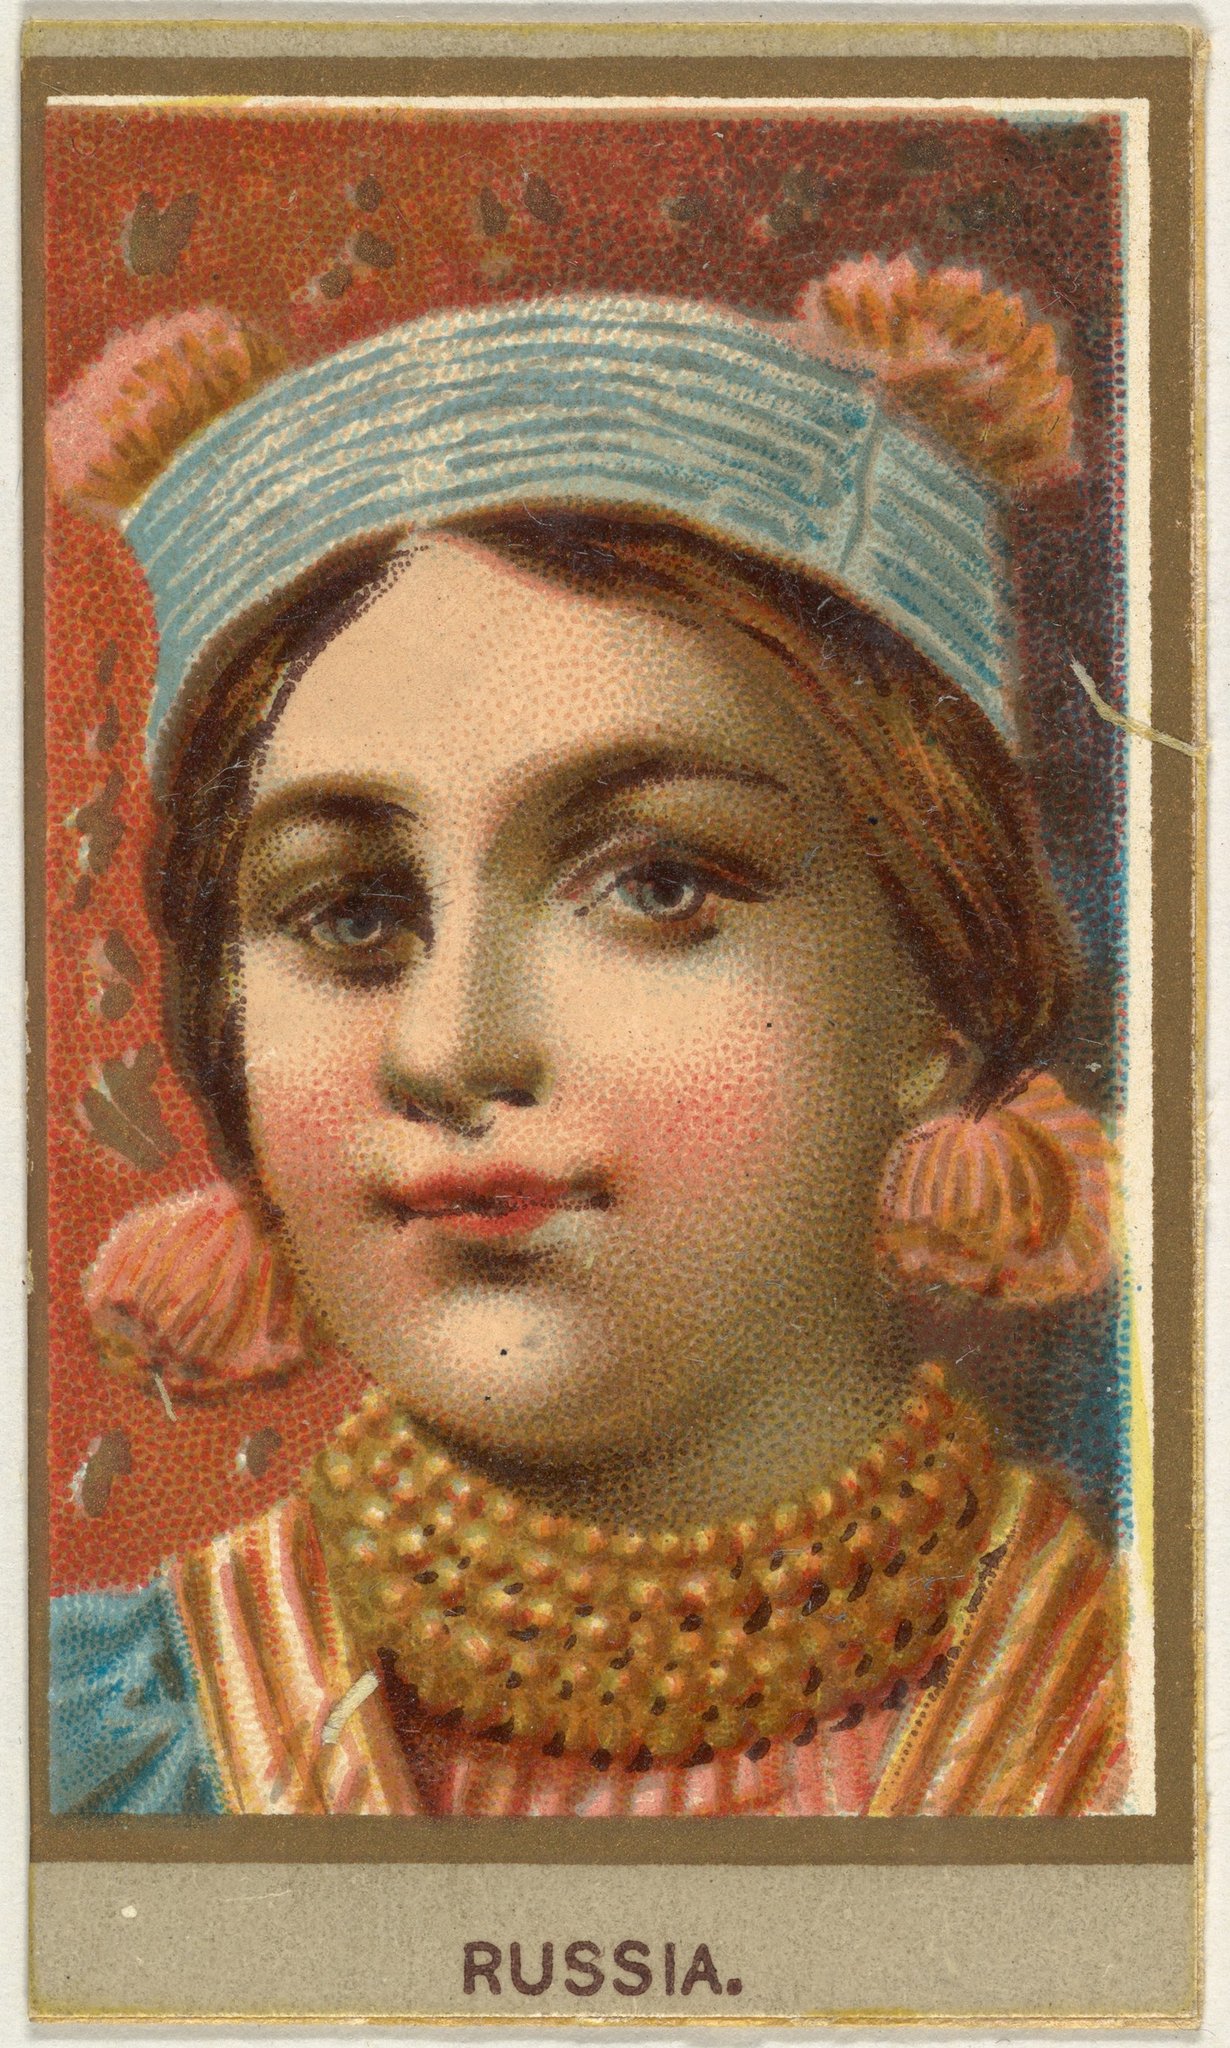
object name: print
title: Russia, from the Races of Mankind series (T181) issued by Abdul Cigarettes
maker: abdul cigarettes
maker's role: publisher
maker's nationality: american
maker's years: 1881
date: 1881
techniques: color lithograph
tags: women